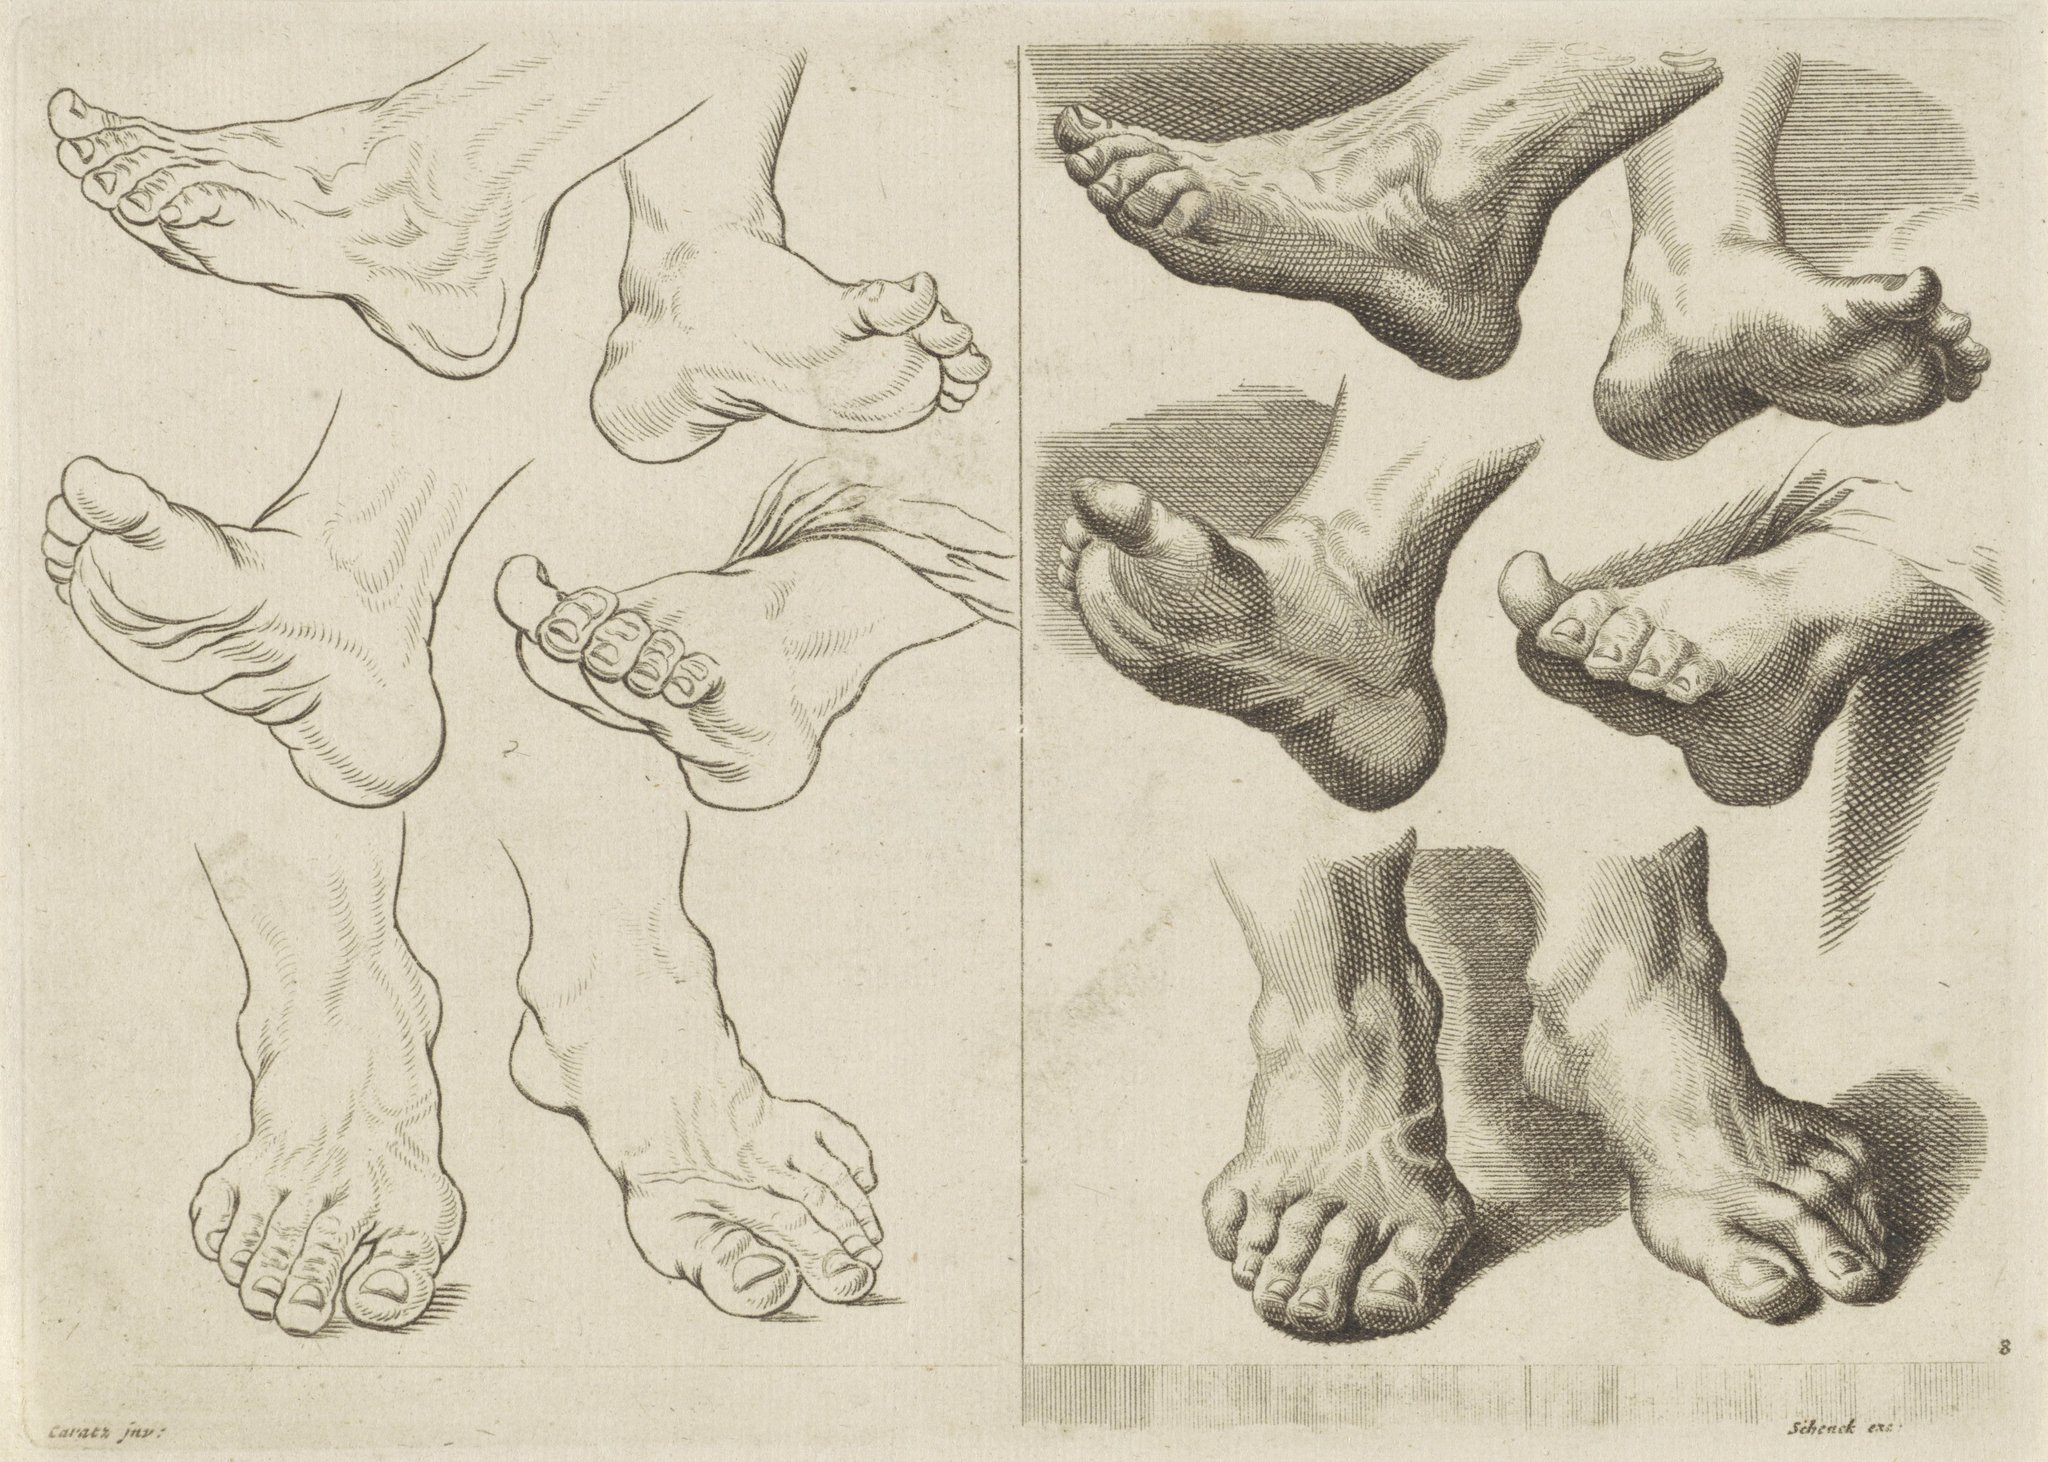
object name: print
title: Figuren naar Annibale Carracci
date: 1675-1711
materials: paper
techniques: engraving, etching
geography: amsterdam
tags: foot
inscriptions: collector's mark: Lugt 2228